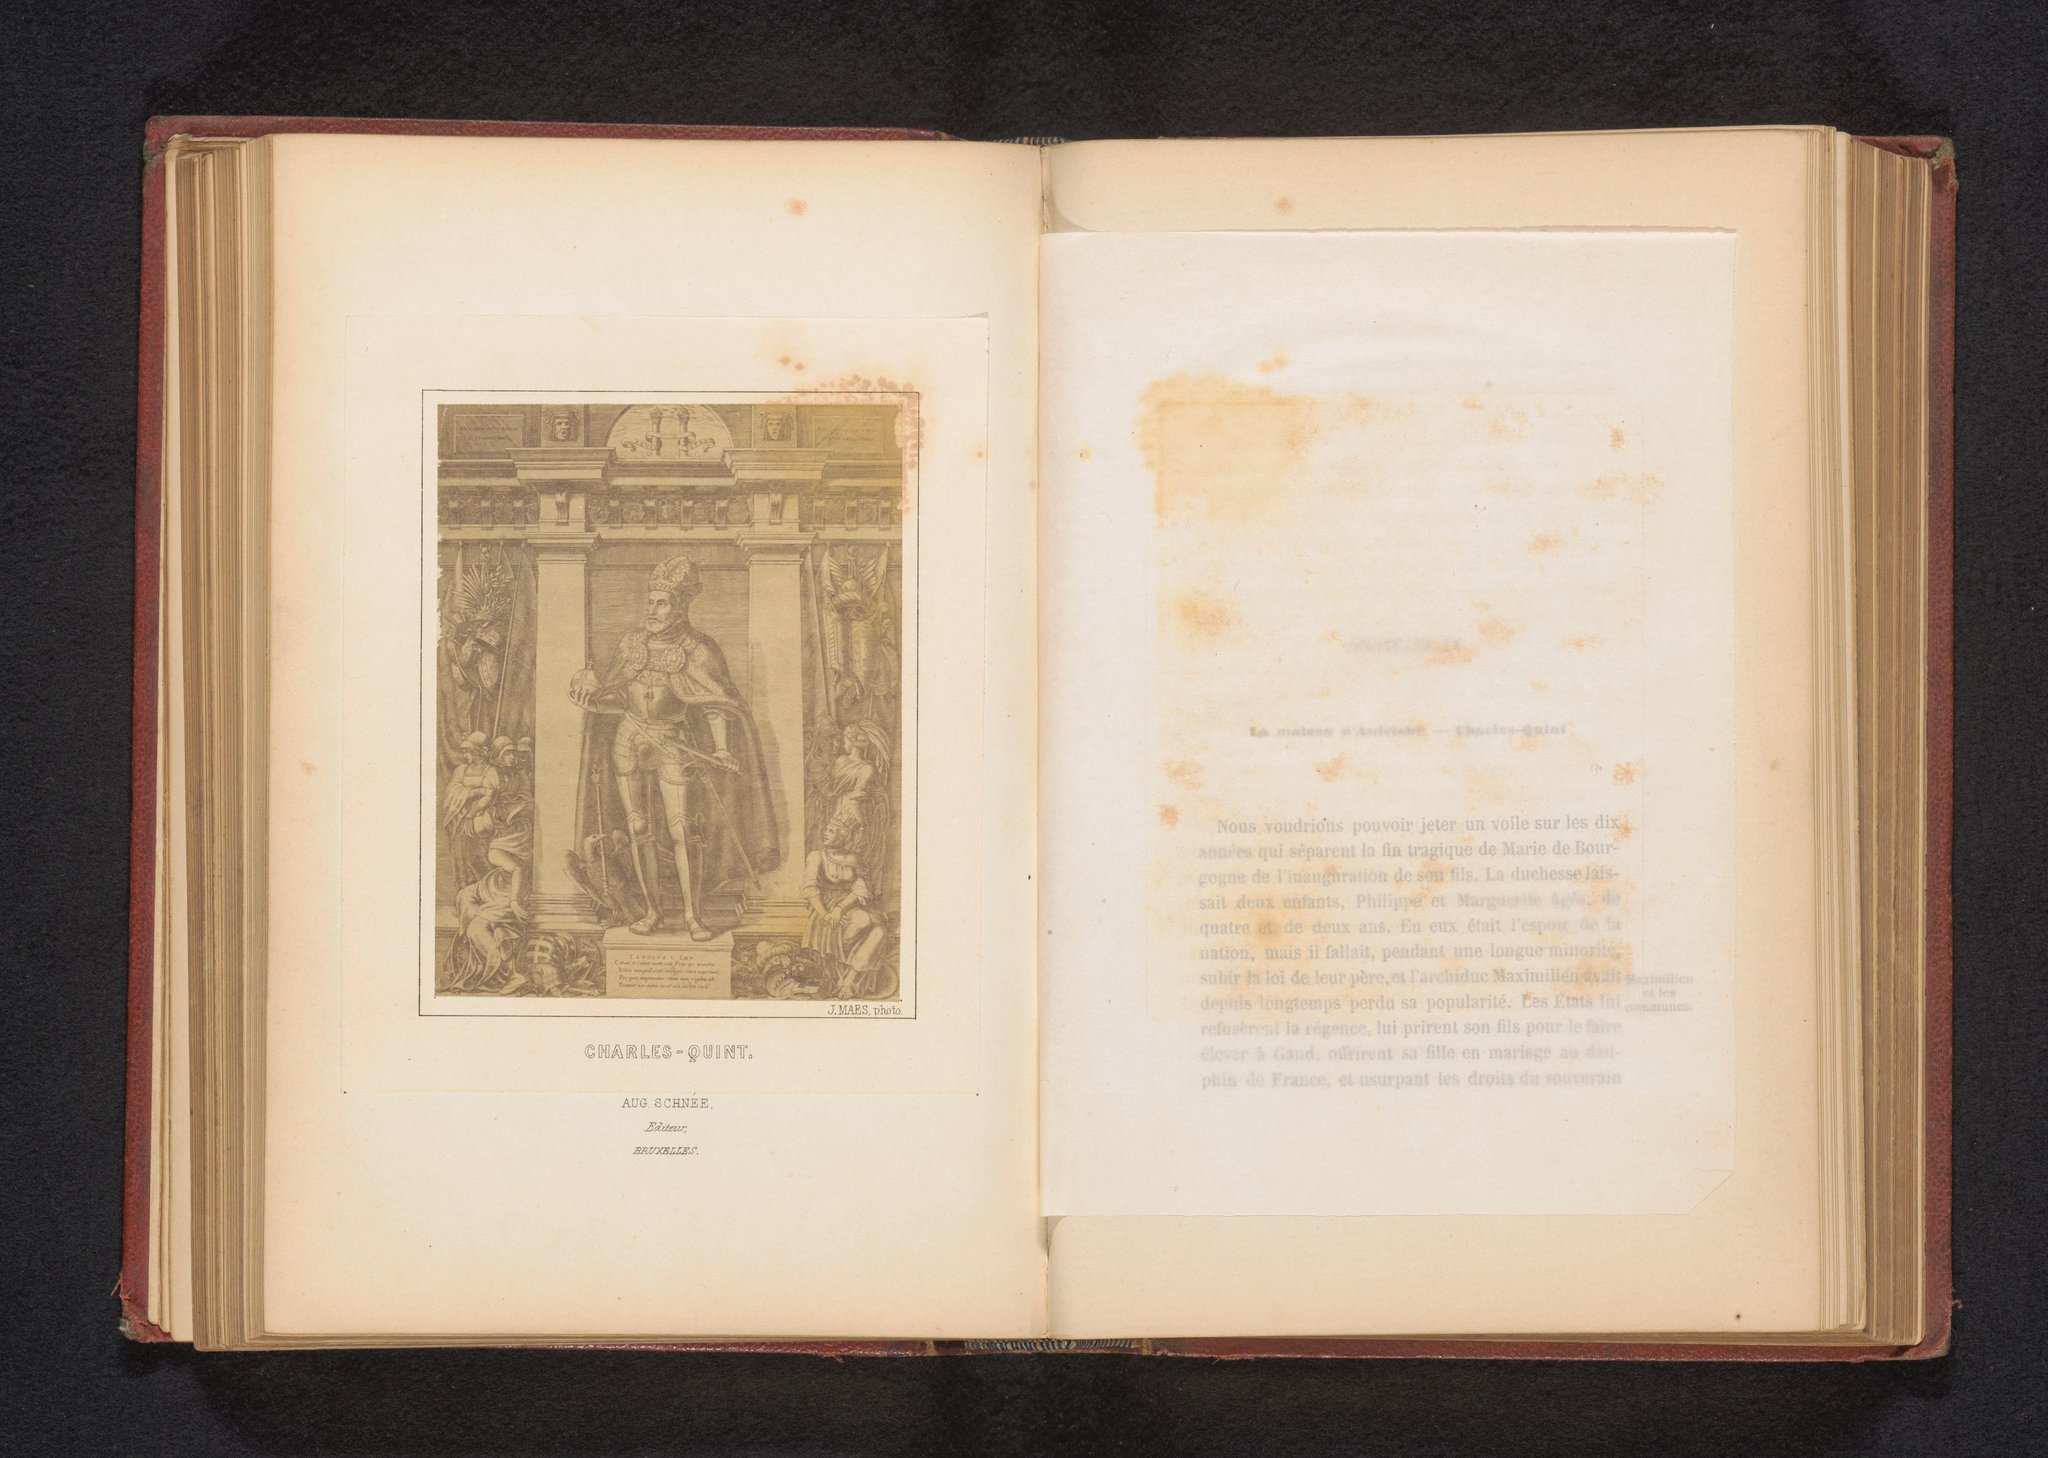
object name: photograph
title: Charles Quint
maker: joseph maes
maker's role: fotograaf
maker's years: 1838-1908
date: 1855-1860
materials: photographic support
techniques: albumen print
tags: ghent, charles v (holy roman emperor and king of spain), historical persons